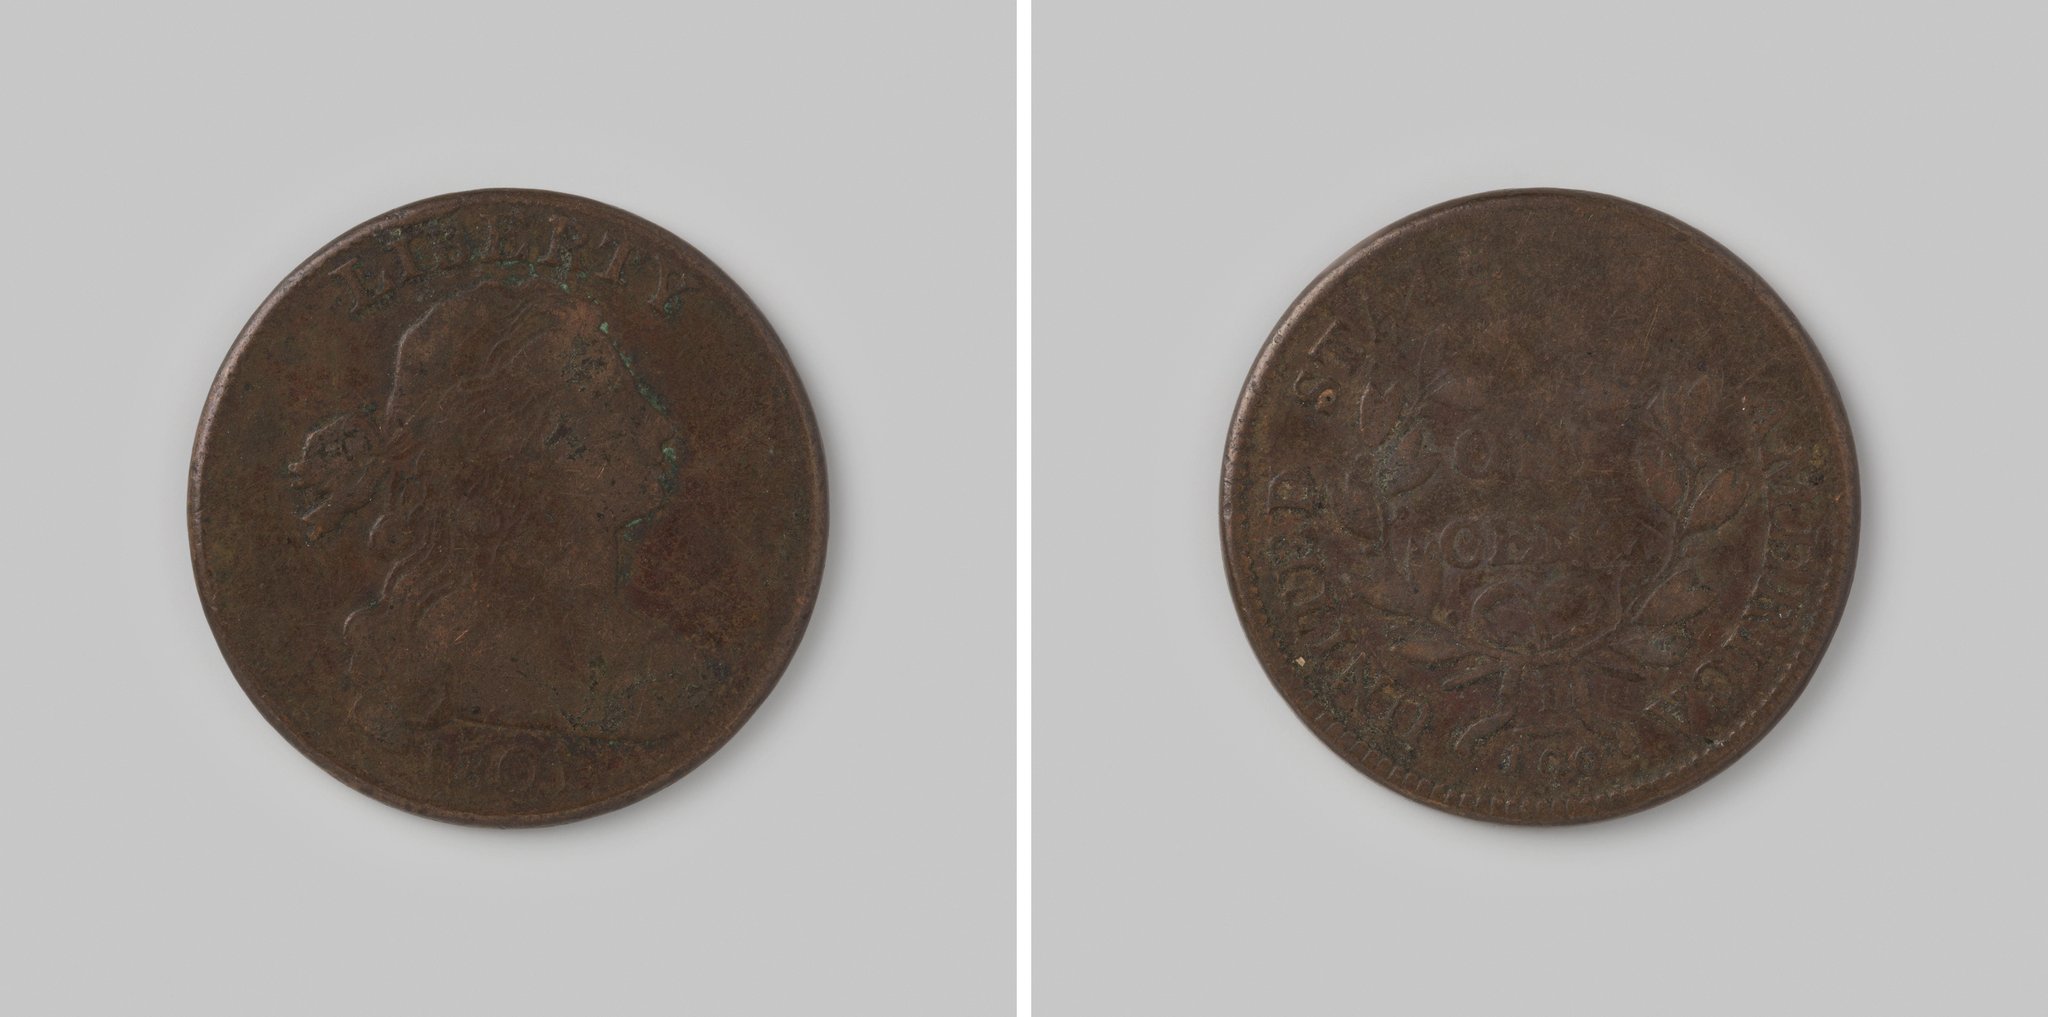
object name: coin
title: Verenigde Staten van Amerika, cent, 1801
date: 1801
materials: copper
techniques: striking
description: Koperen munt. Voorzijde: liberty (draped bust) naar rechts. Onderaan jaartal. Keerzijde: tussen twee met grote strik samengebonden takken waarde-aanduiding: one cent in twee regels. Onderaan tussen linten waarde-aanduiding: 1/100. Gladde rand.